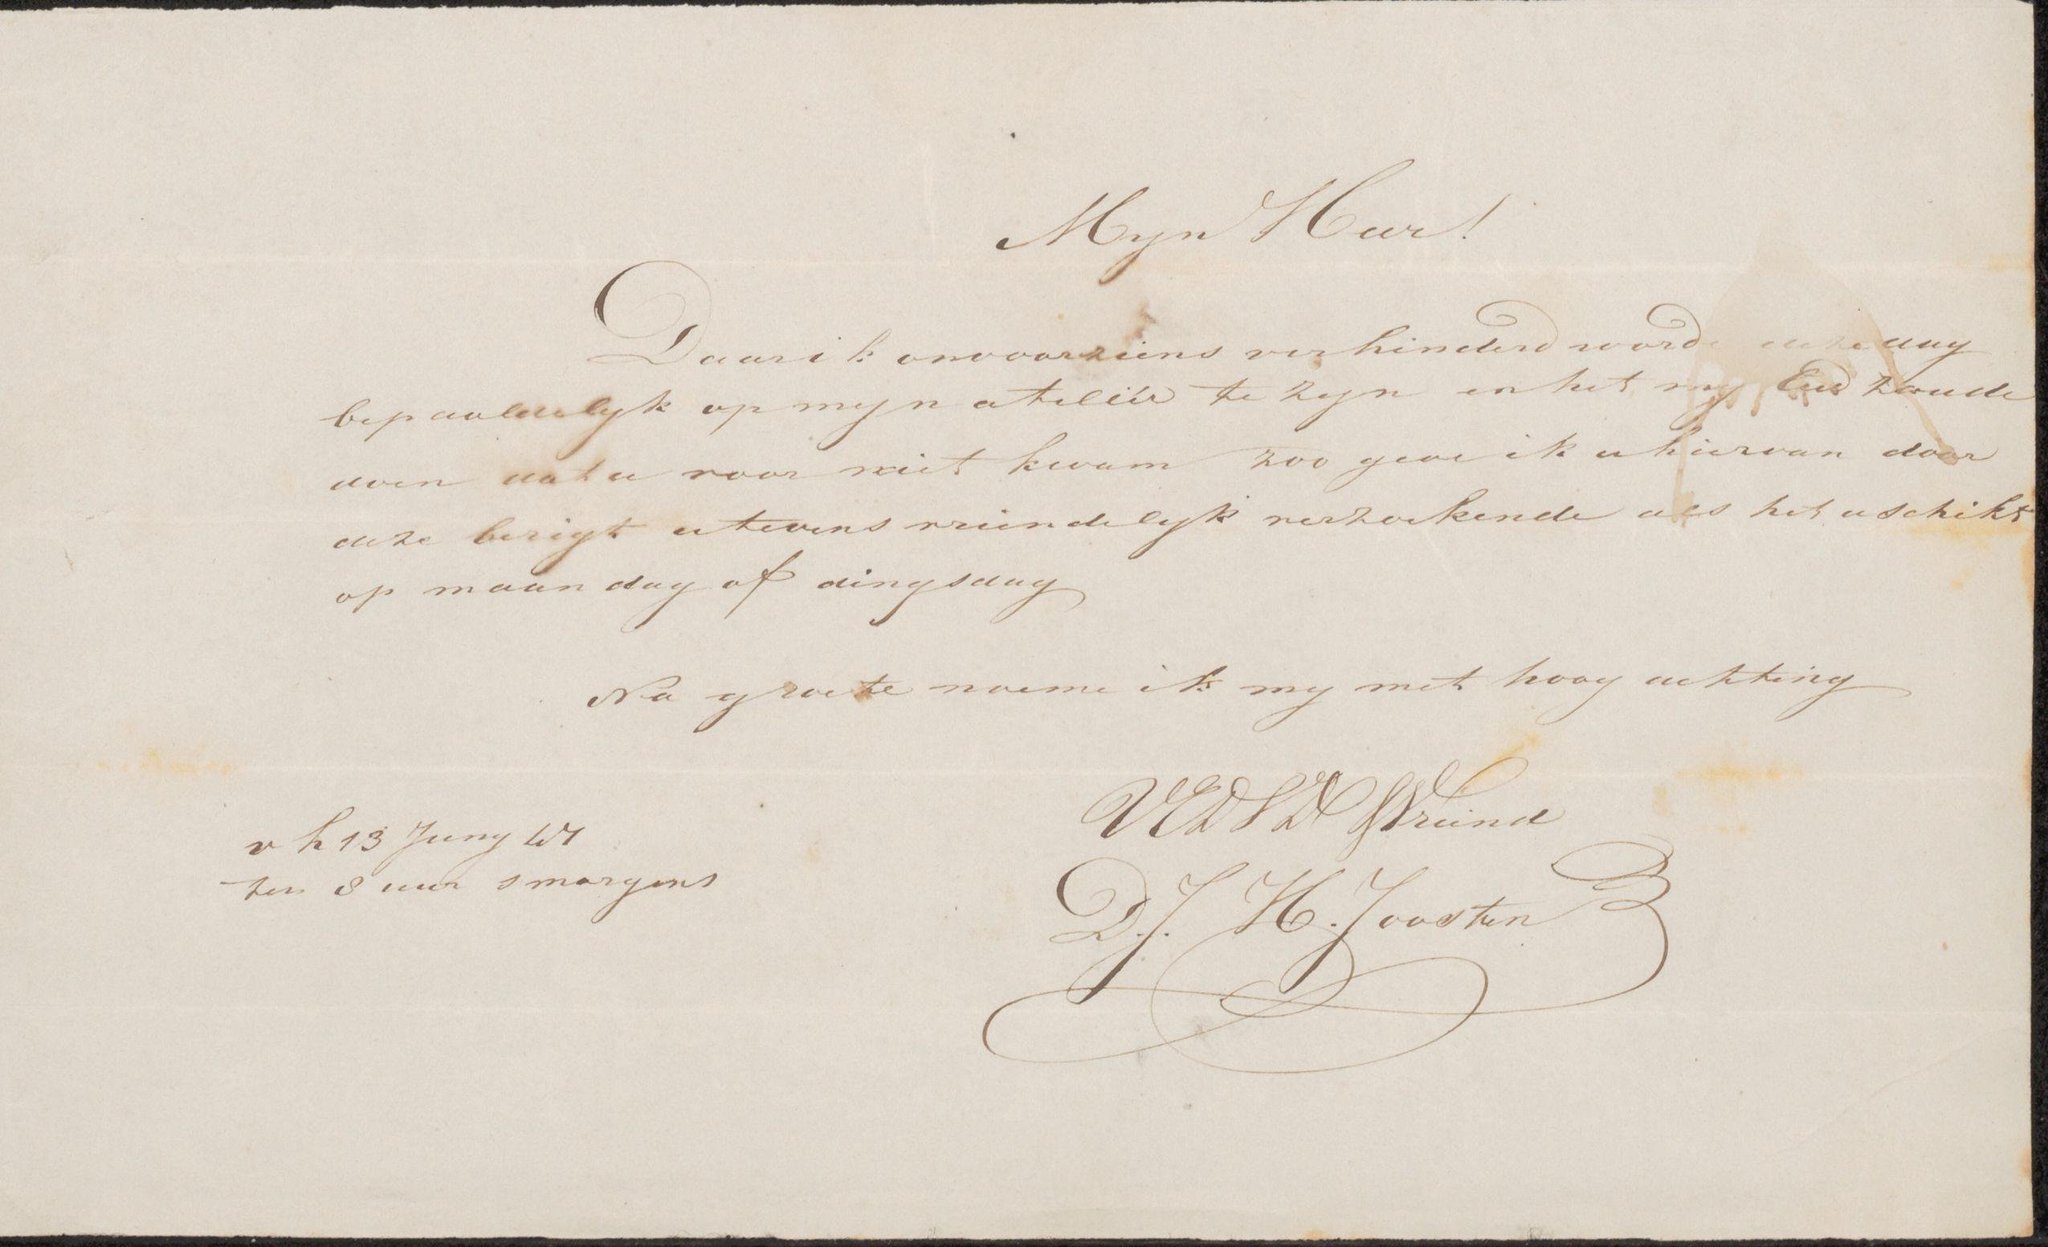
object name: letter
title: Brief aan Simon van den Berg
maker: dirk jan hendrik joosten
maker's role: draughtsman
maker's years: 1818-1882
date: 1847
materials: ink, paper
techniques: pen, writing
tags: overschie, arnhem, draughtsman, simon van den berg, workshop, studio of the artist (in general)